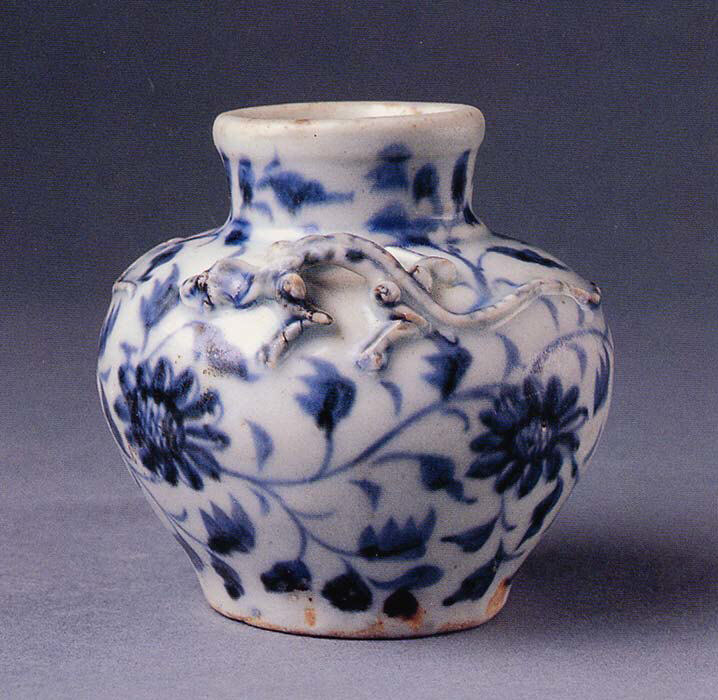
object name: jar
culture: chinese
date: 1301-1400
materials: porcelain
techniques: painting, relief, underglaze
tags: flowers